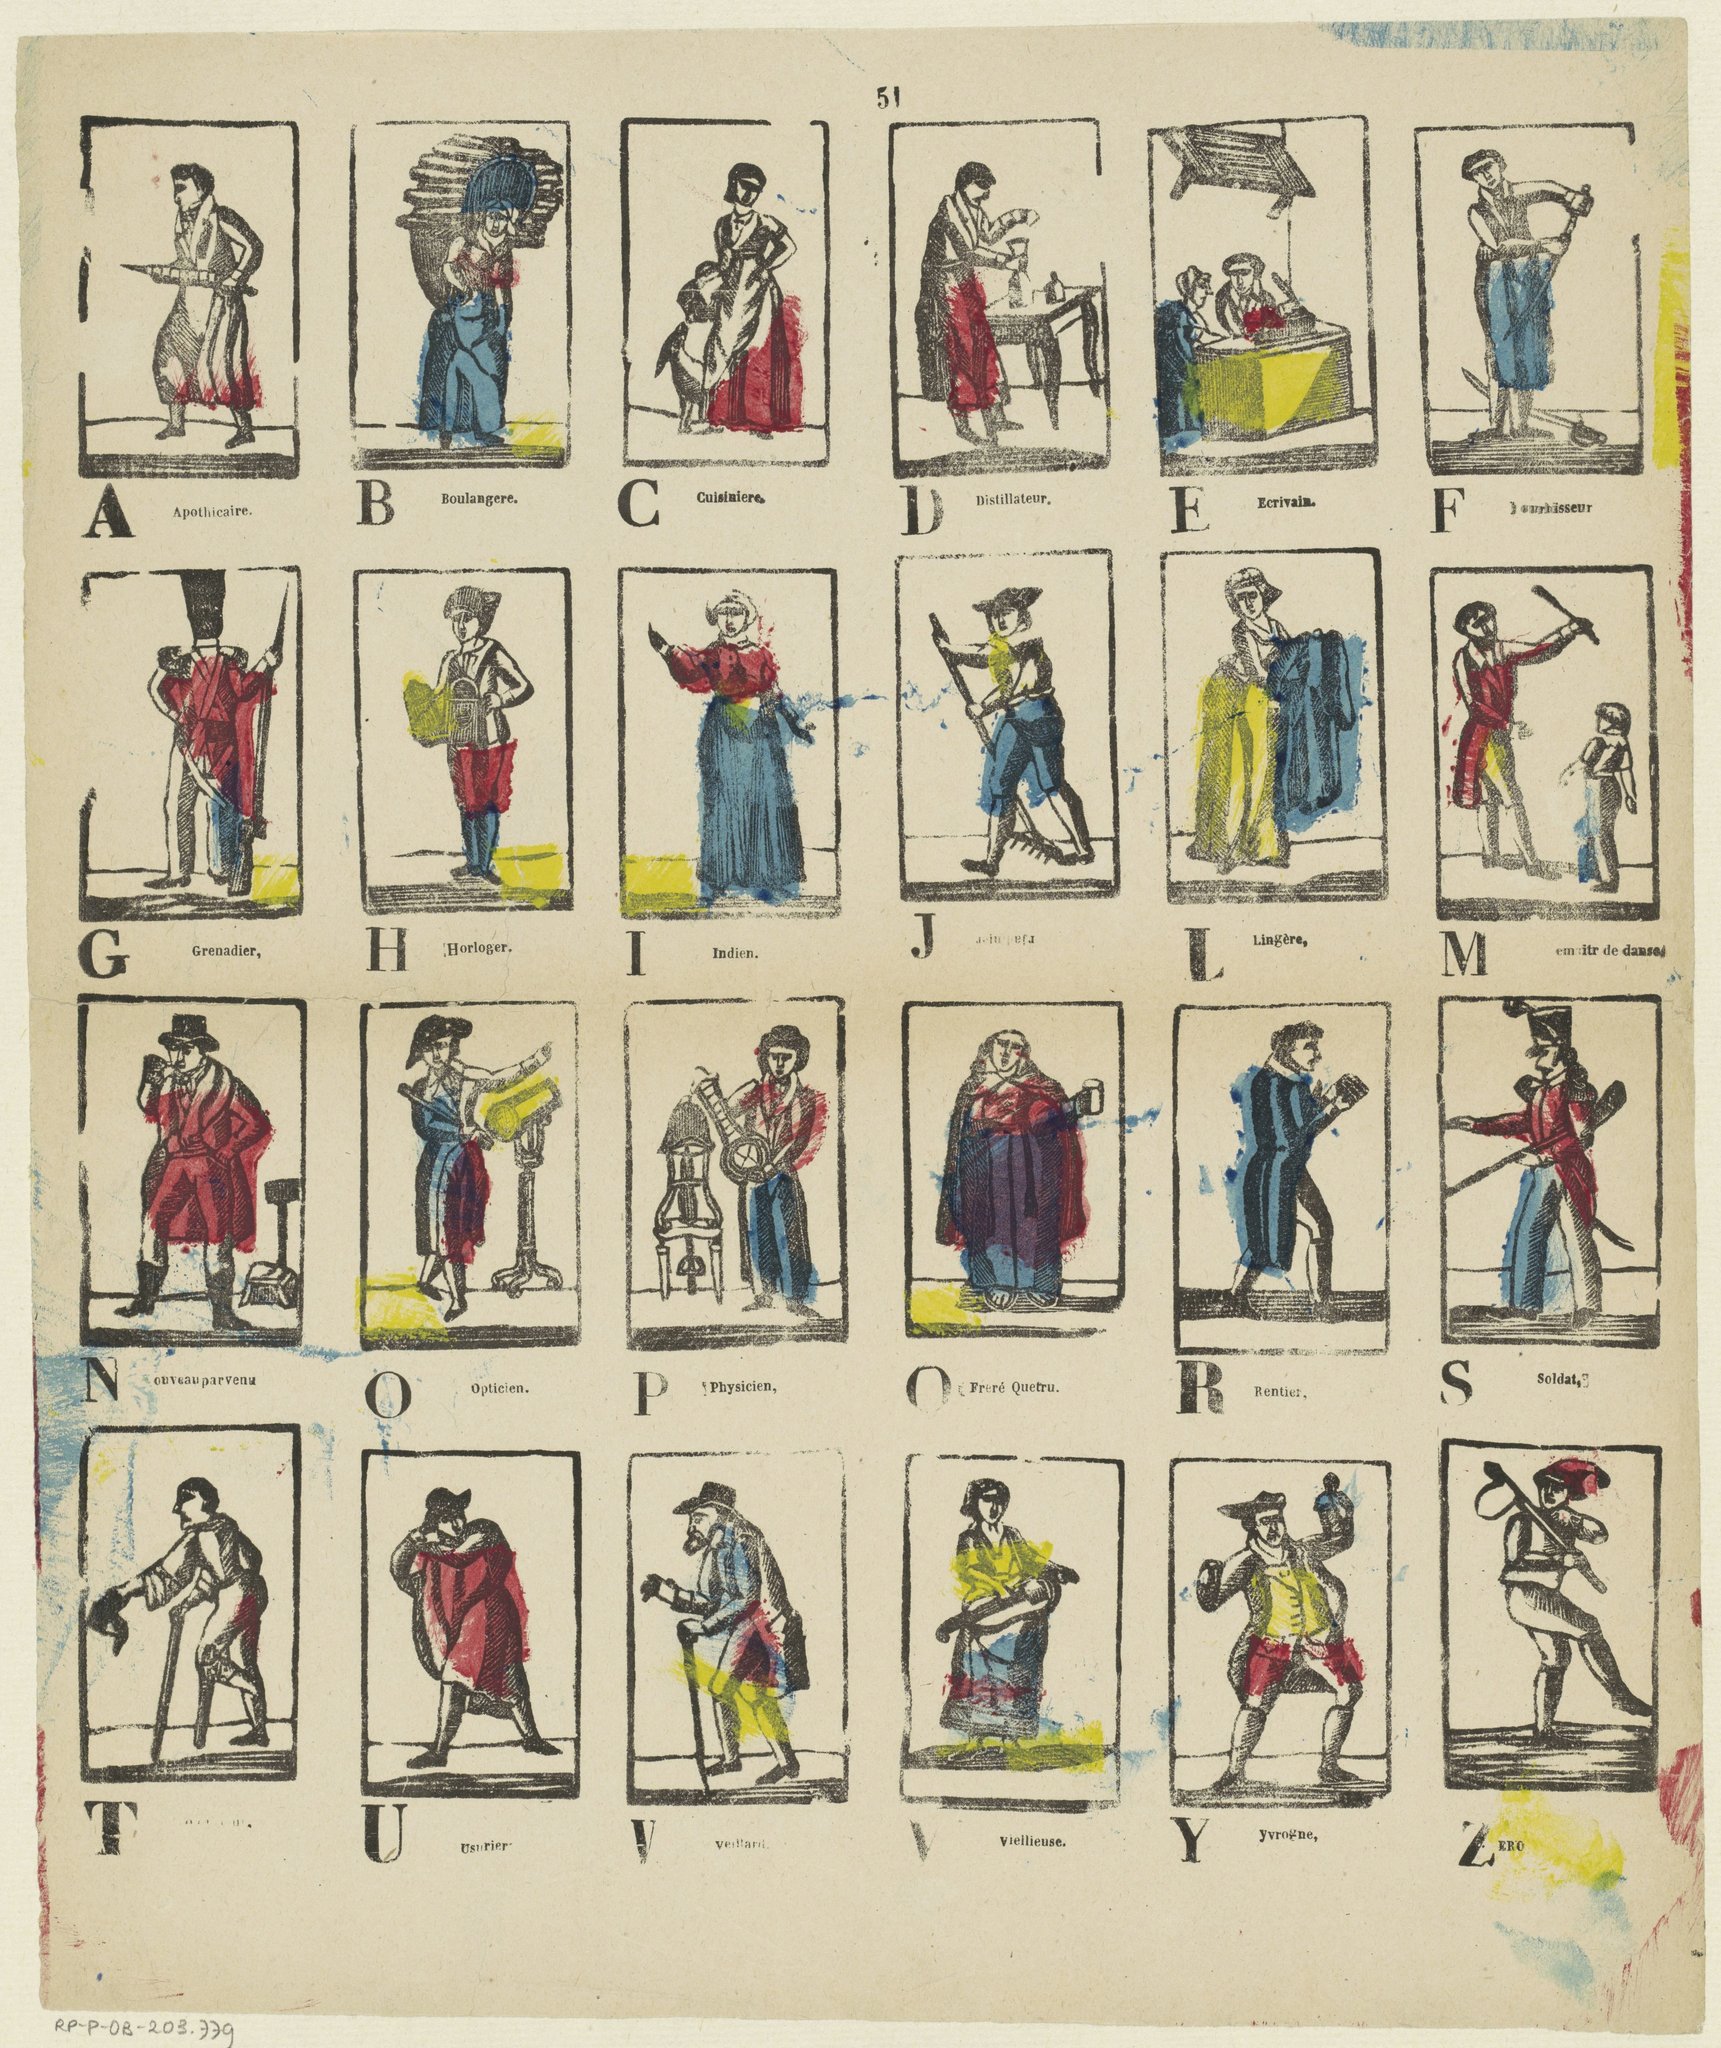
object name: print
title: Alfabet met figuren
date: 1827-1894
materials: paper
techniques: colour, letterpress printing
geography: schaarbeek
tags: letters, alphabet, script, working class, labourers, characters (human types)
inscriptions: collector's mark: Lugt 2760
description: Blad met 24 voorstellingen van de letters van het alfabet geïllustreerd met beroepen en figuren waarvan de woorden met de betreffende letter beginnen. Onder elke afbeelding een onderschrift in het Frans. Genummerd midden boven: 51.